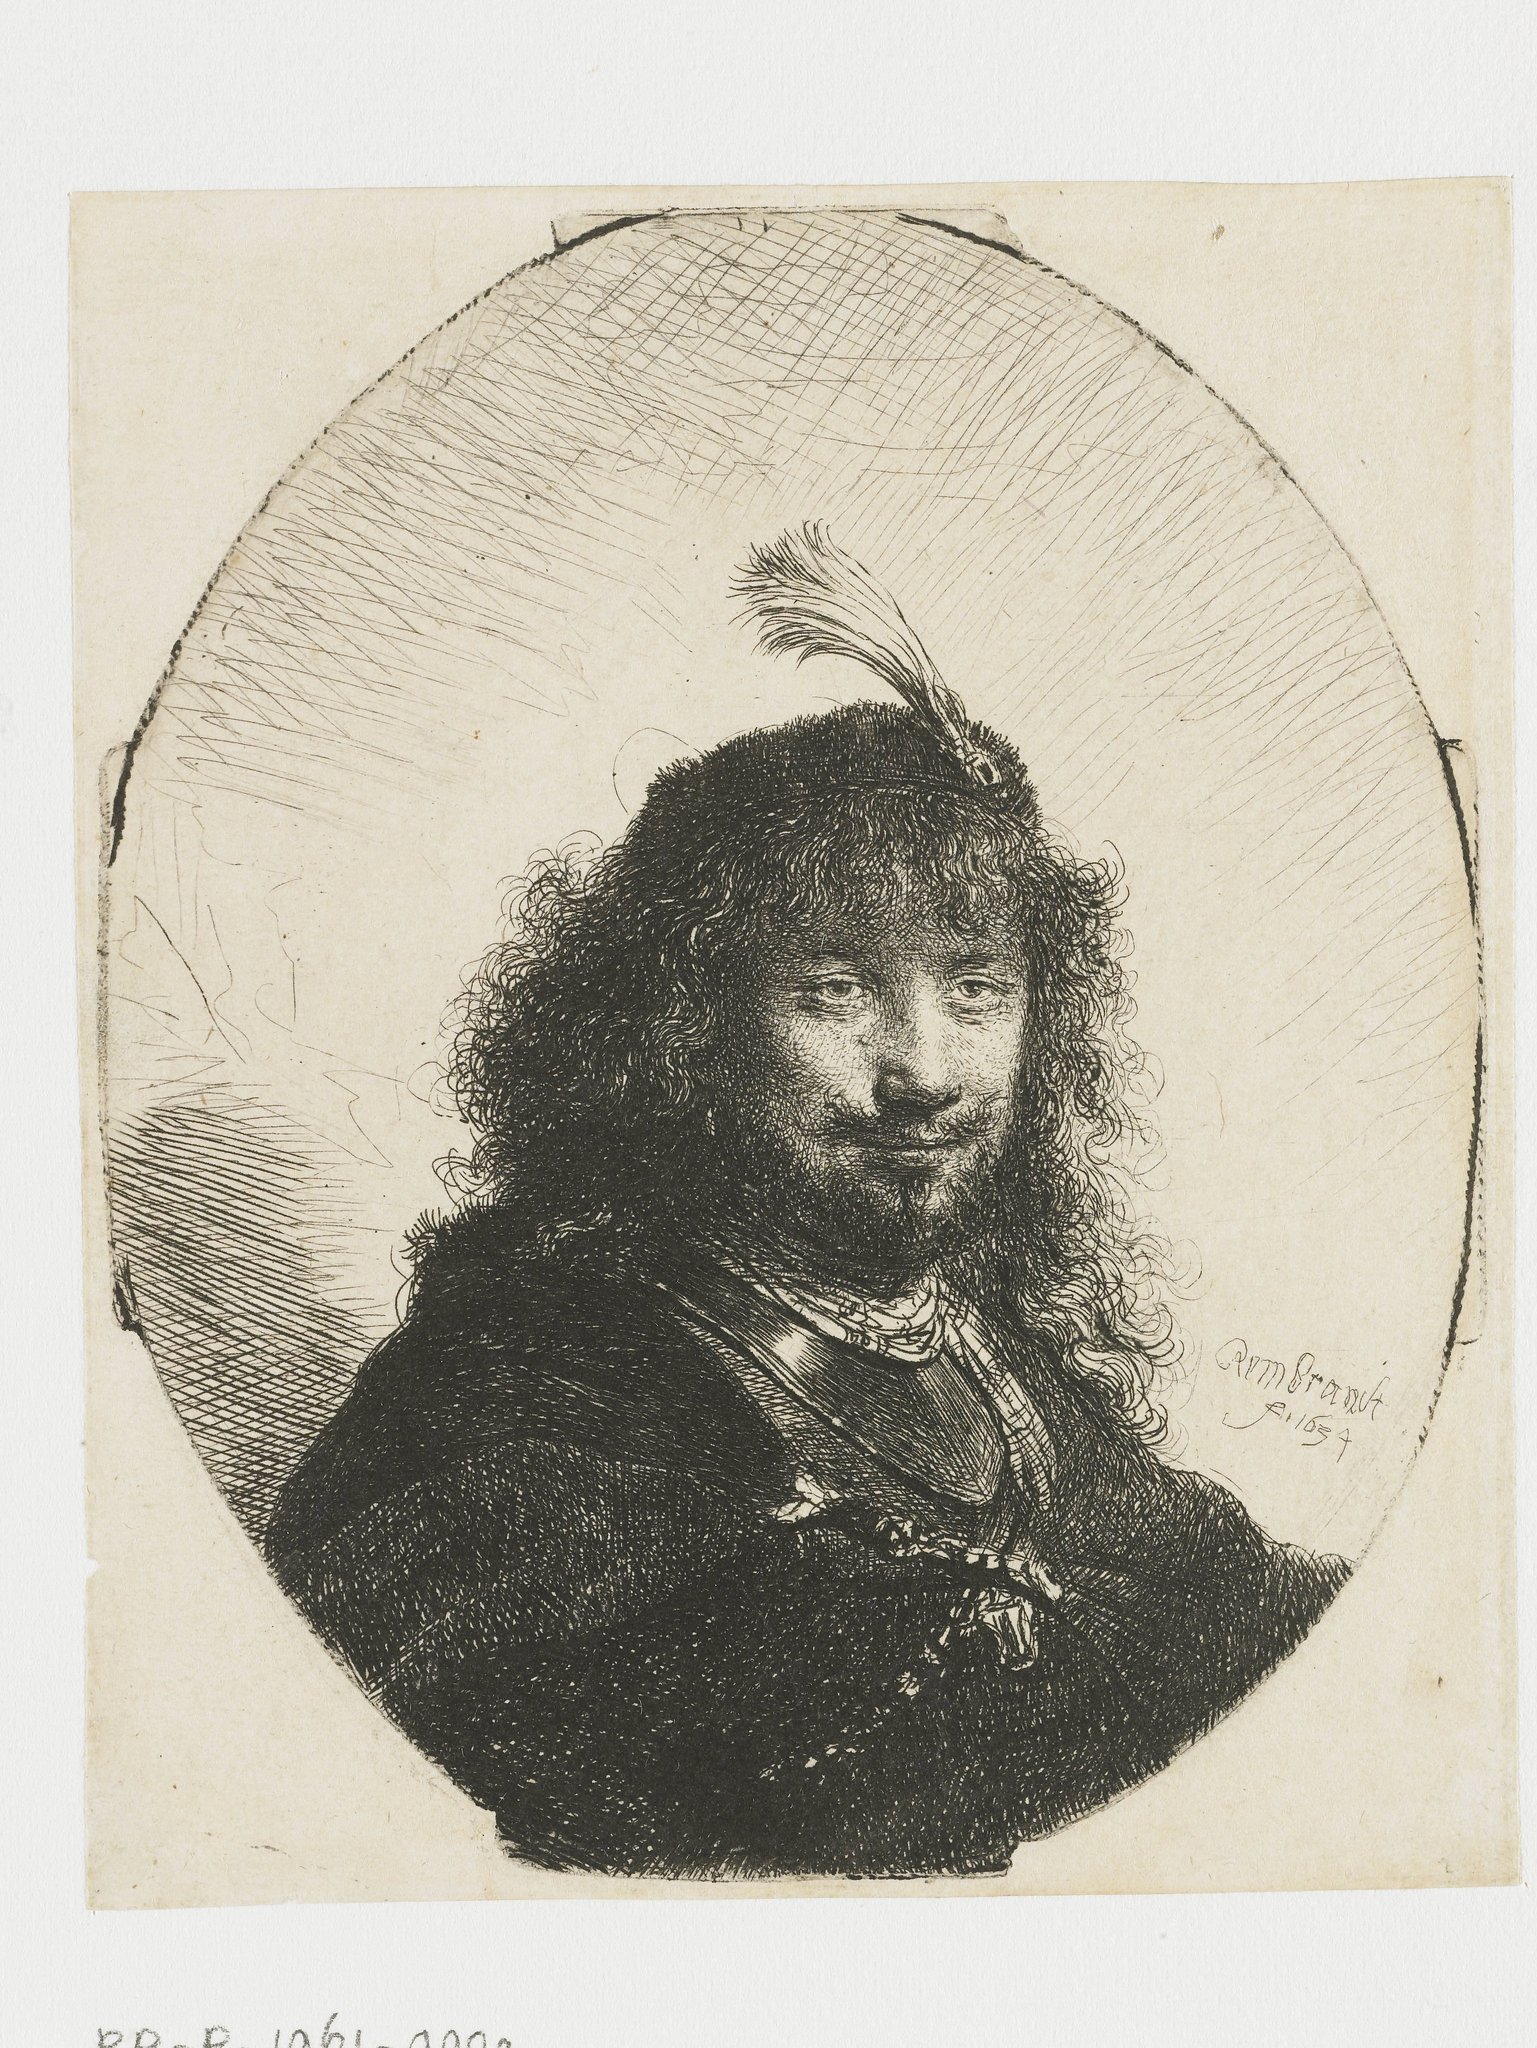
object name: print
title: Self-portrait (?) with plumed cap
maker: rembrandt van rijn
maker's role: draughtsman, painter, print maker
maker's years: 1606-1669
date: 1634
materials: paper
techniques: etching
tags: leiden, amsterdam, painter, print maker, draughtsman, rembrandt van rijn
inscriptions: collector's mark: Lugt 2228, collector's mark: Lugt 1383, signature and date: ‘Rembrandt f. 1634’, collector's mark: Lugt 1052 a